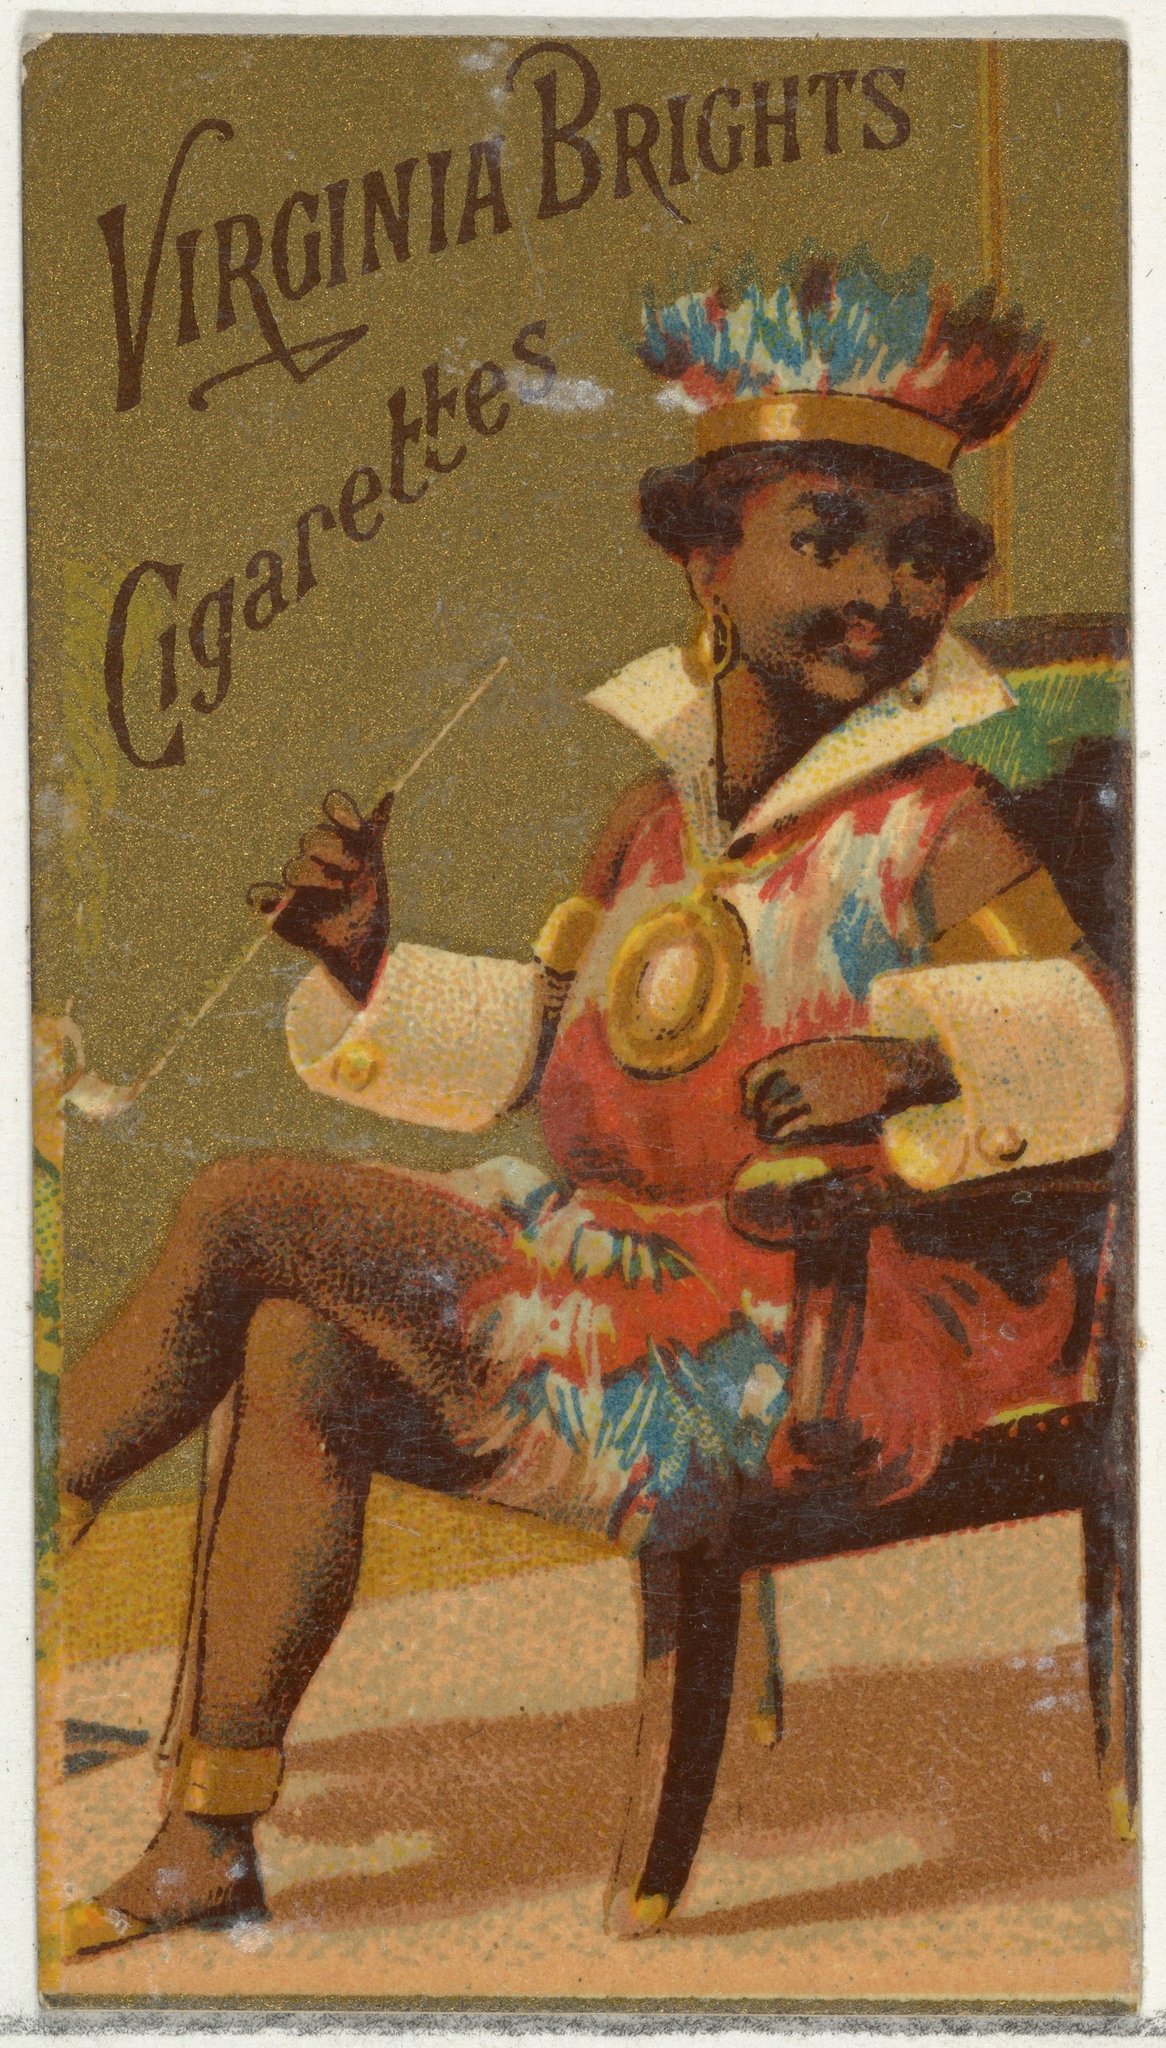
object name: print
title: Caricatured Figure (with pipe) from the Girls and Children series (N64) promoting Virginia Brights Cigarettes for Allen & Ginter brand tobacco products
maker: allen & ginter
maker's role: publisher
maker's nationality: american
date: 1886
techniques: color lithograph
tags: girls